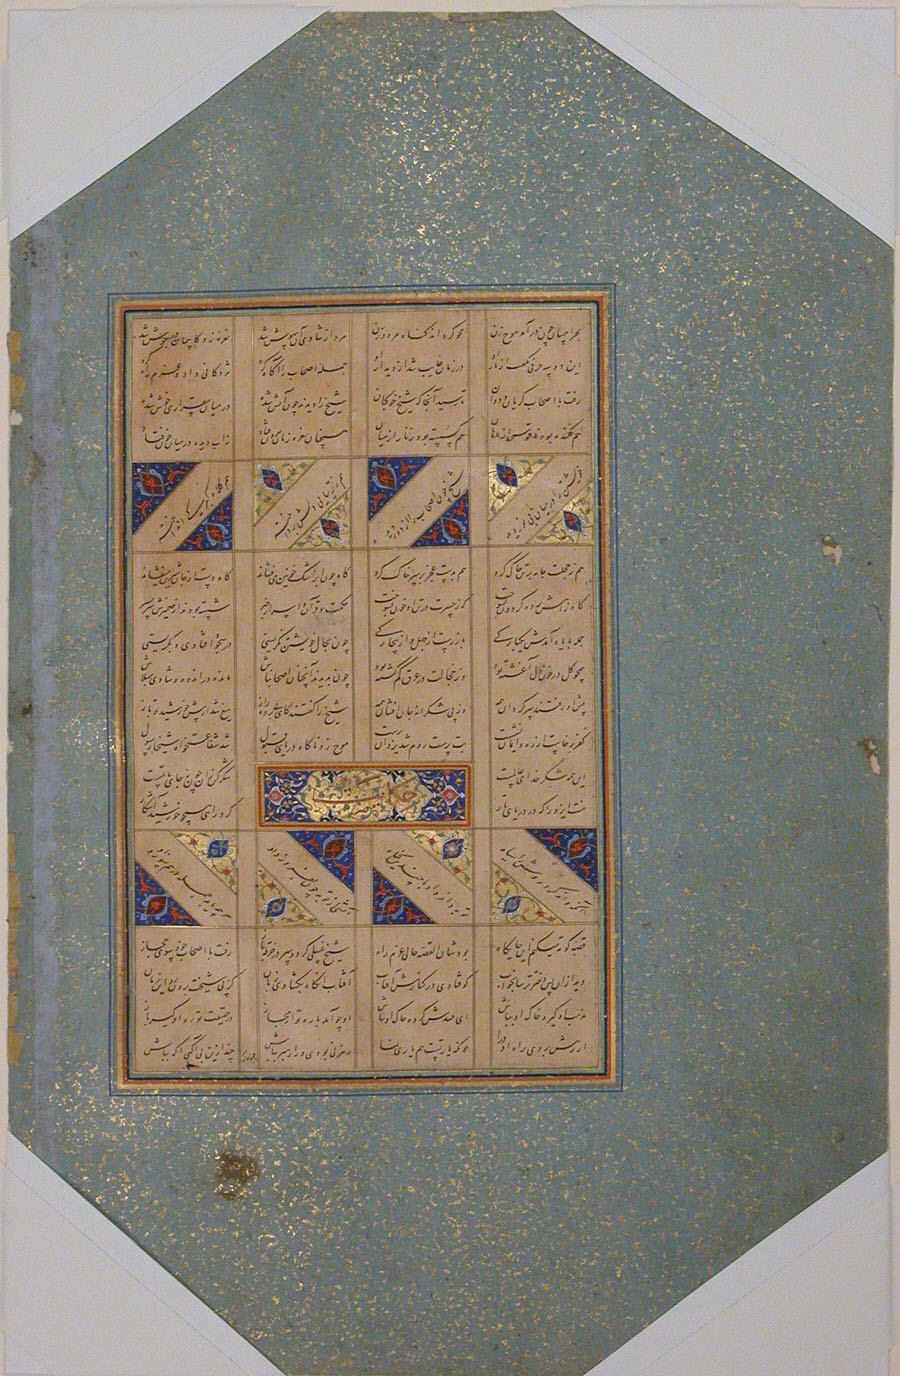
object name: folio from an illustrated manuscript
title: Page of Calligraphy from a Mantiq al-Tayr (Language of the Birds)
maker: farid al-din `attar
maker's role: author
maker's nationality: iranian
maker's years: 1142-1220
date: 1600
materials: gold, ink, paper, silver, watercolor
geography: iran